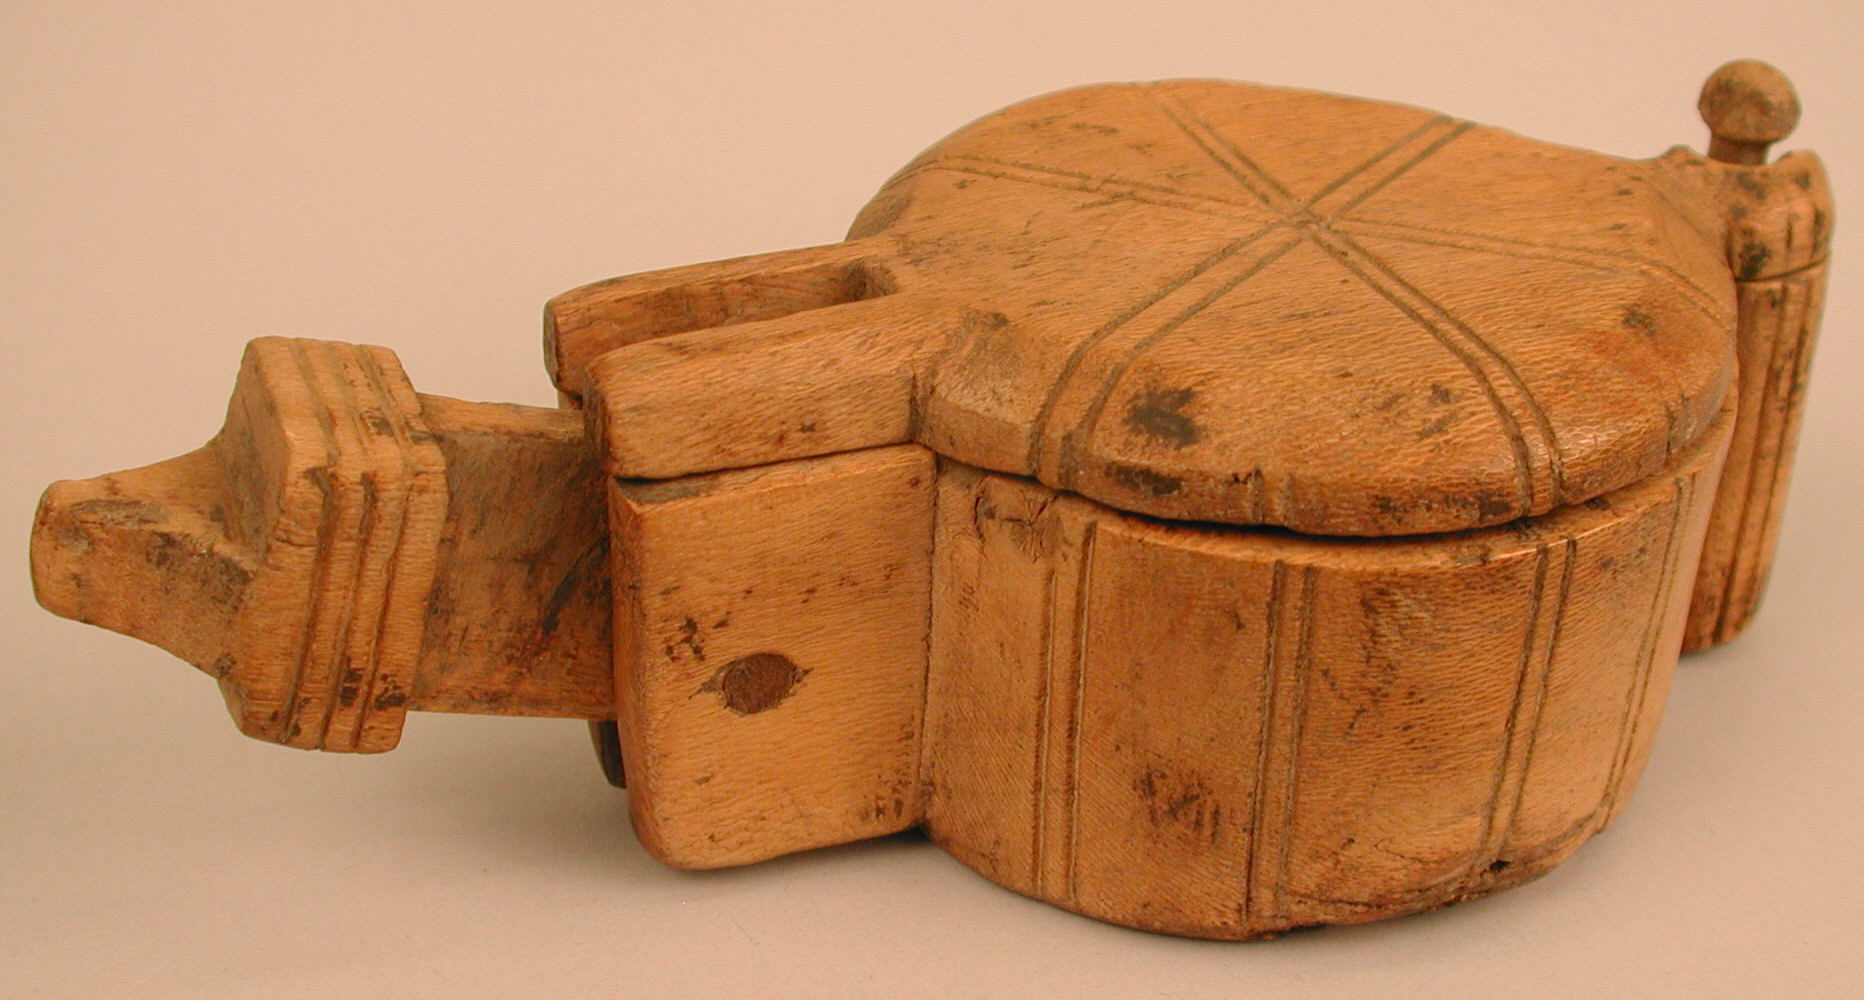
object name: box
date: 601-700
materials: wood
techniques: carving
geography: egypt